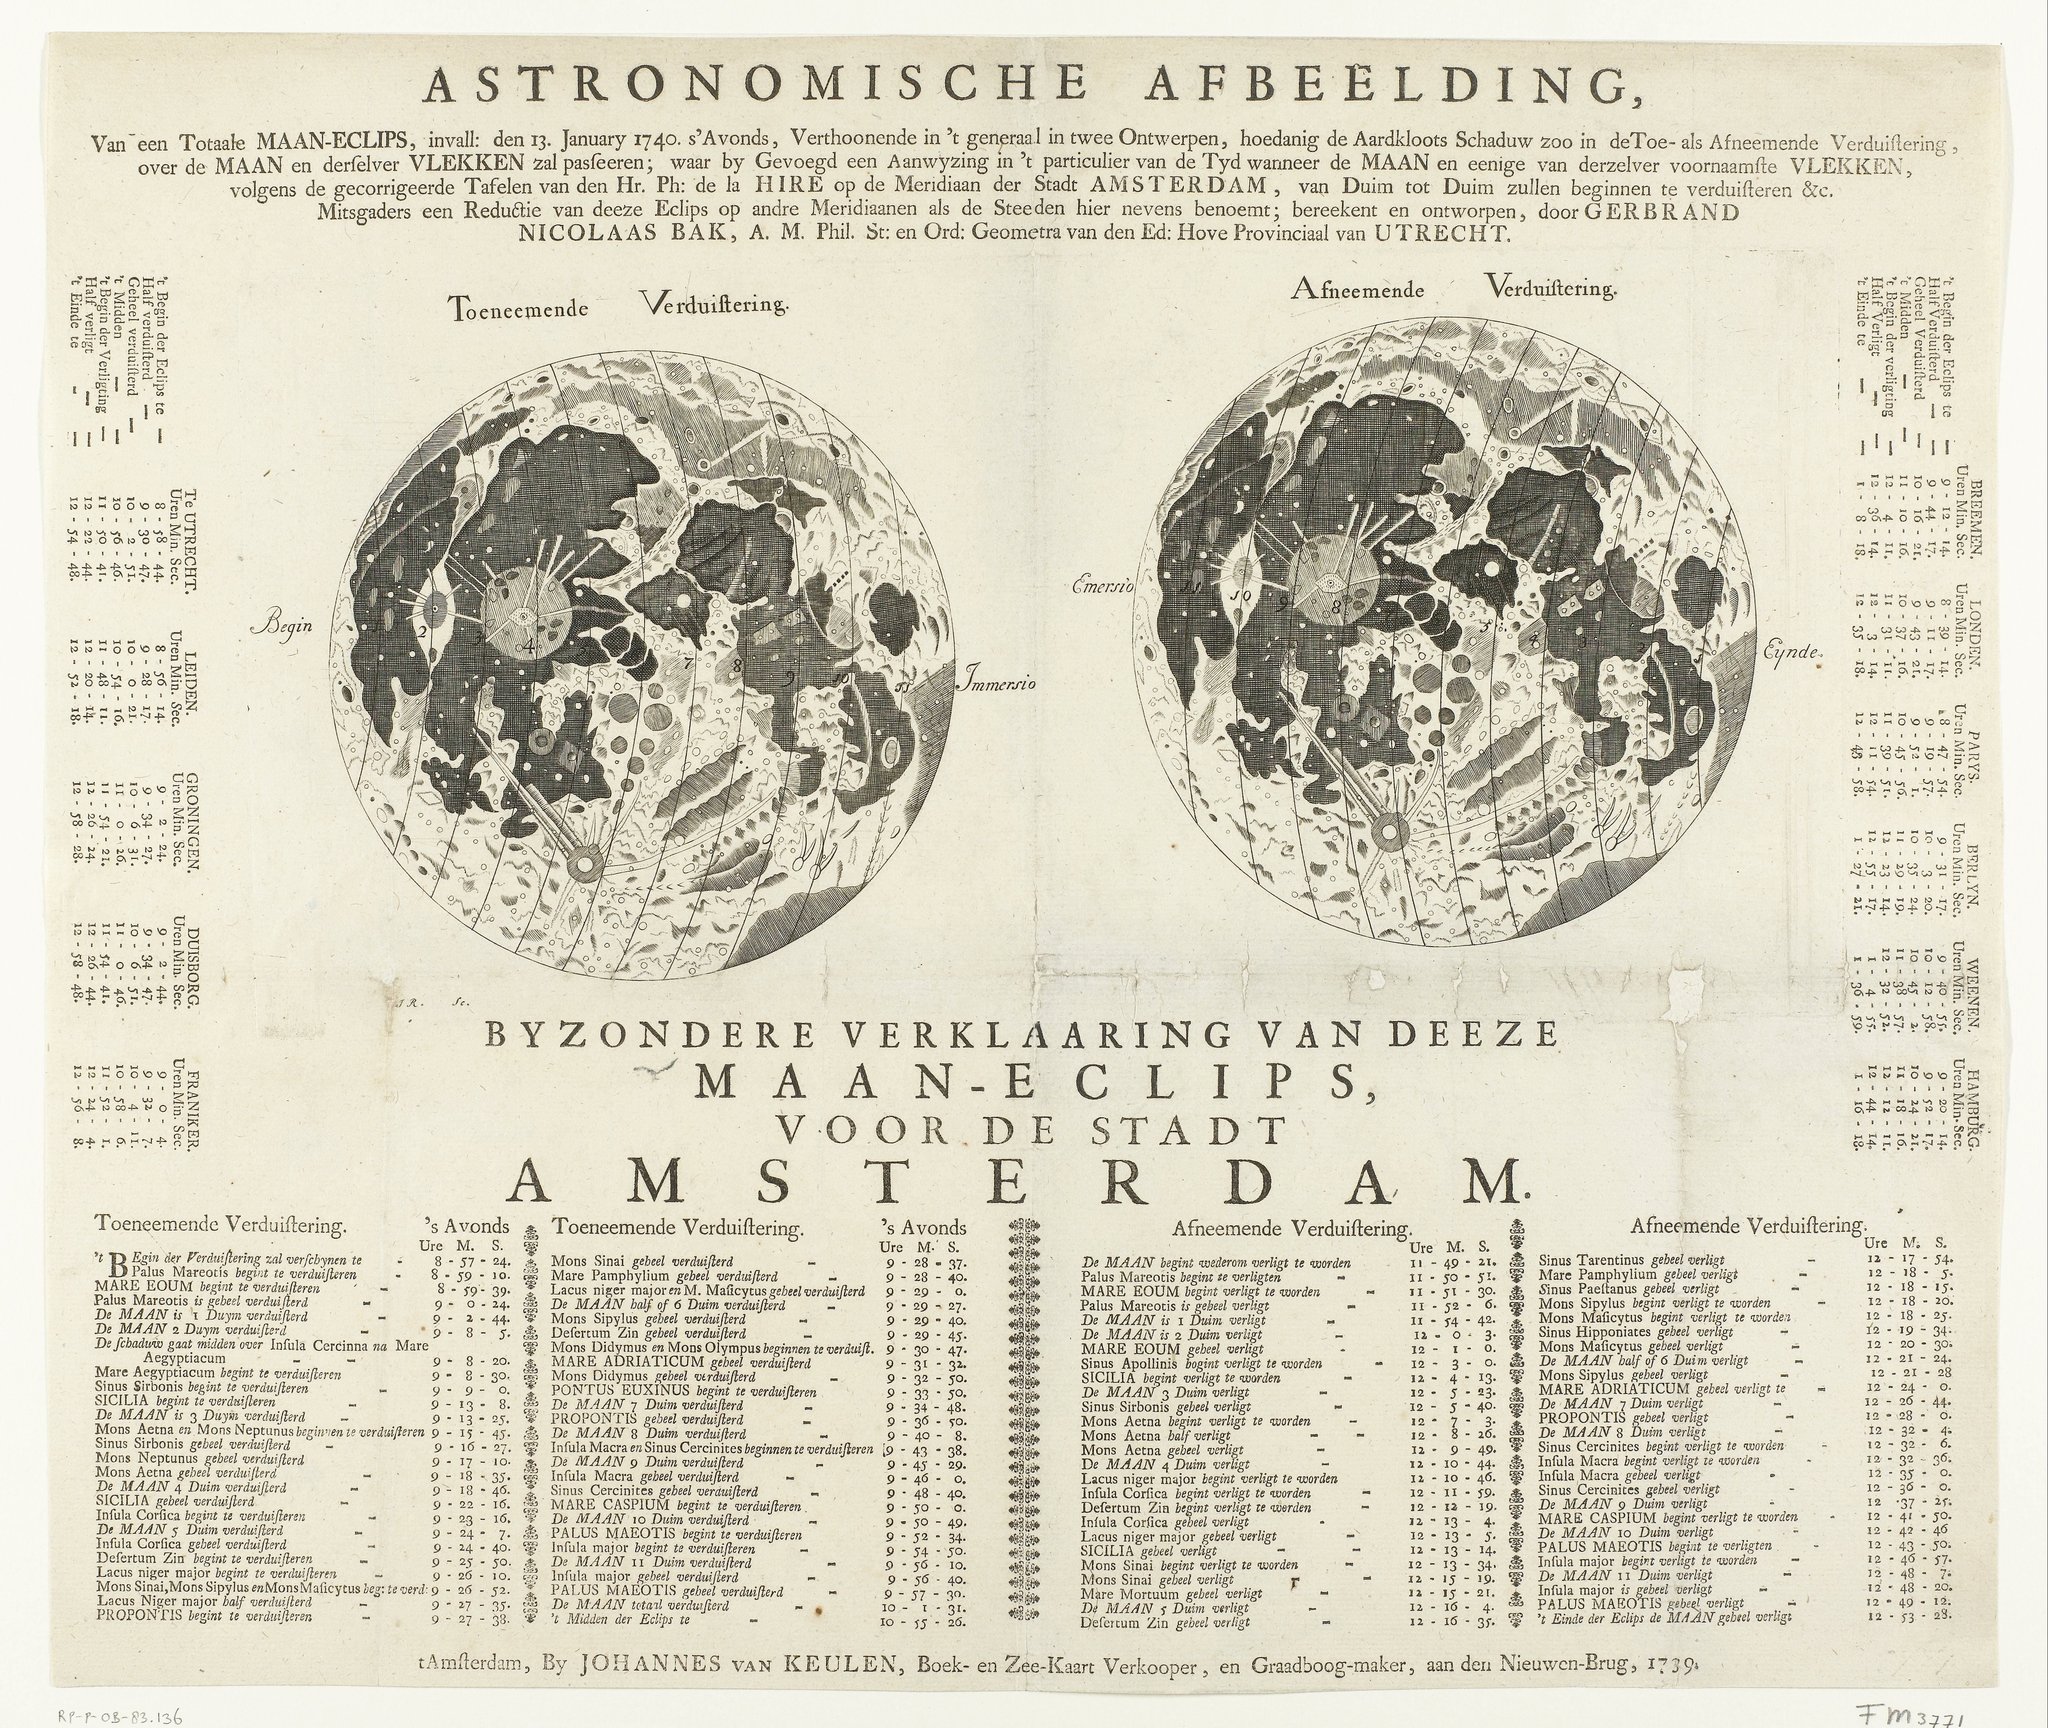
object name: print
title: Maansverduistering van 1740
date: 1739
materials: paper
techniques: engraving, letterpress printing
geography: amsterdam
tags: eclipse of the moon, moon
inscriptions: date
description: Bericht over de aanstaande maansverduistering van 13 januari 1740. Twee voorstellingen van de maan met de zones van voortschreidende en afnemende verduistering. Op het blad om de plaat tekst met de titel en tabellen van verduisterde plaatsen op de maan, samengesteld door Gerbrand Nicolaas Bak te Utrecht.